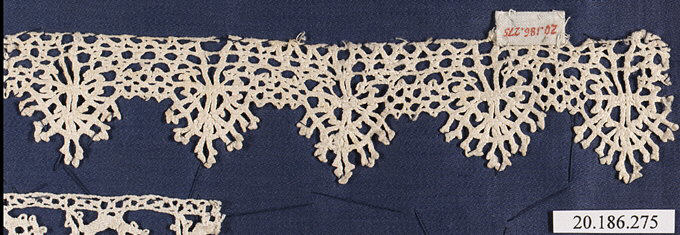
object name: edging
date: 1501-1600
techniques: lace